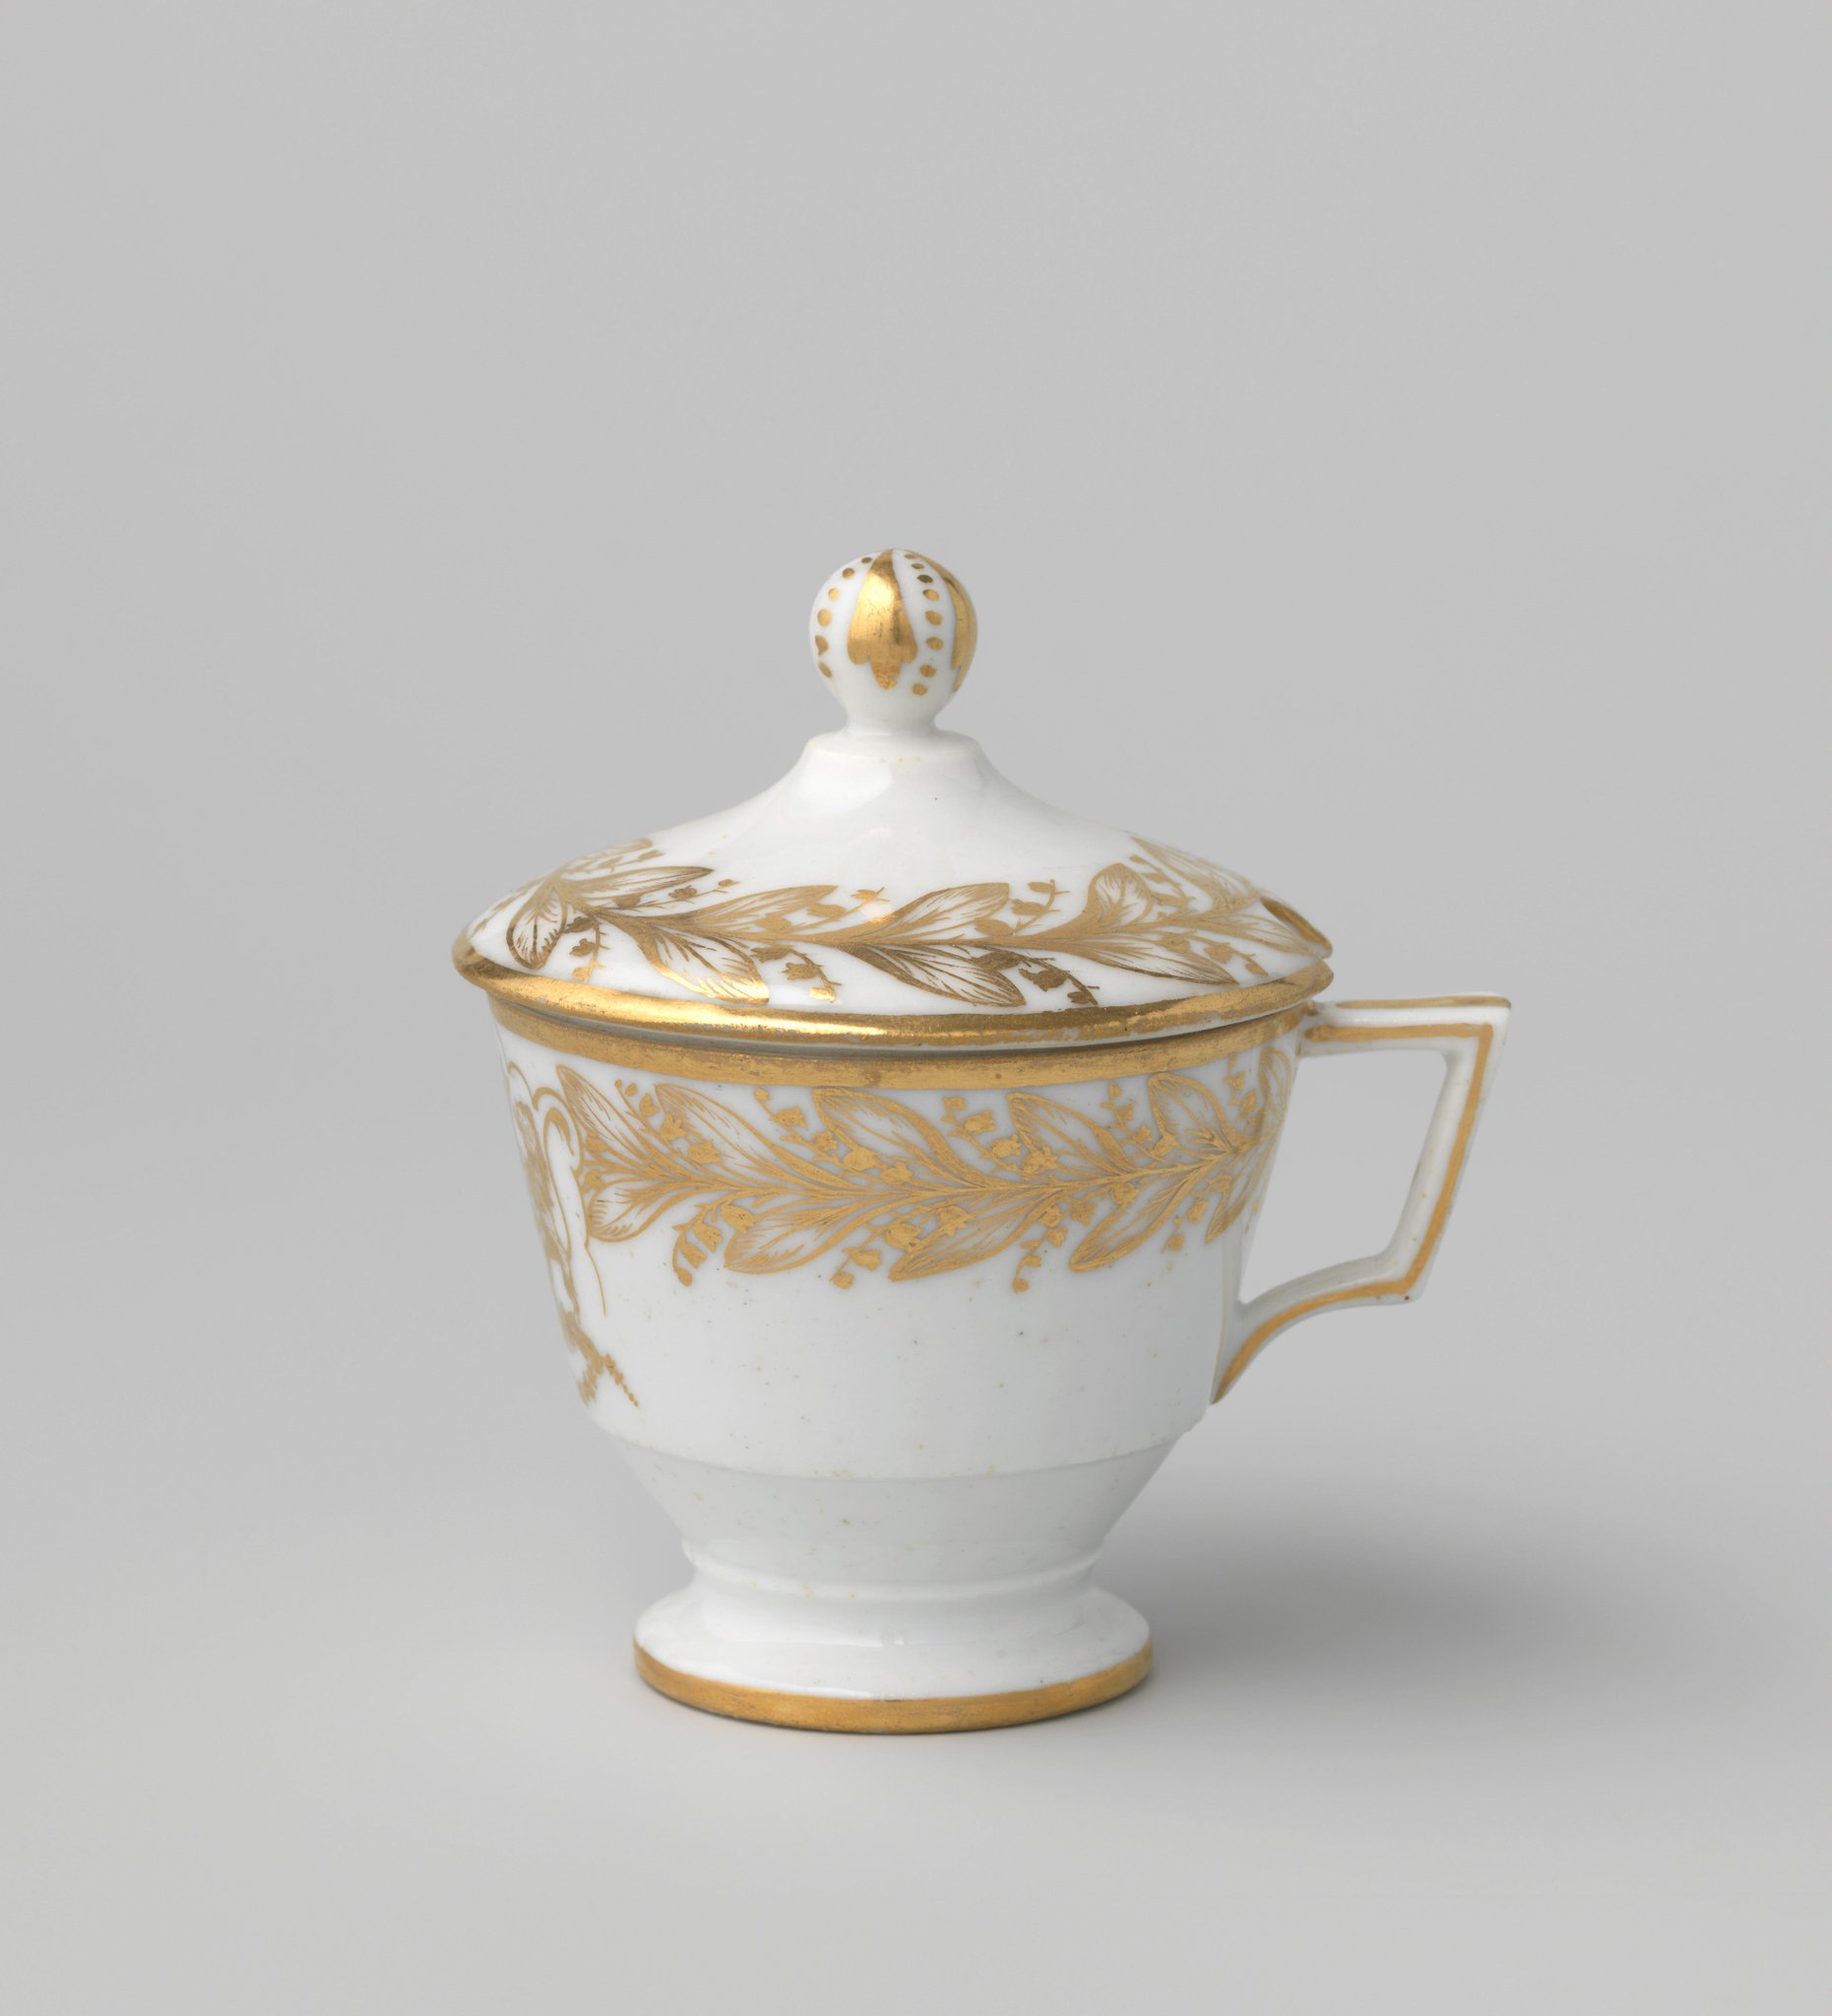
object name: mustard pot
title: Cover of a mustard pot with the coat of arms of Hendrik Peter Godfried Quack and Isabella Gertraud von Carnap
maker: Anonymous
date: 1790-1800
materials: glaze, gold, paint, porcelain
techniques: firing, forming, gilding, turning, vitrification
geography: netherlands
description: Deksel van een mosterpot van porselein, beschilderd op het glazuur met goud. Versierd met een bloemrank en ronde dekselknop. In de rand van de deksel zit een uitsparing voor een lepel.